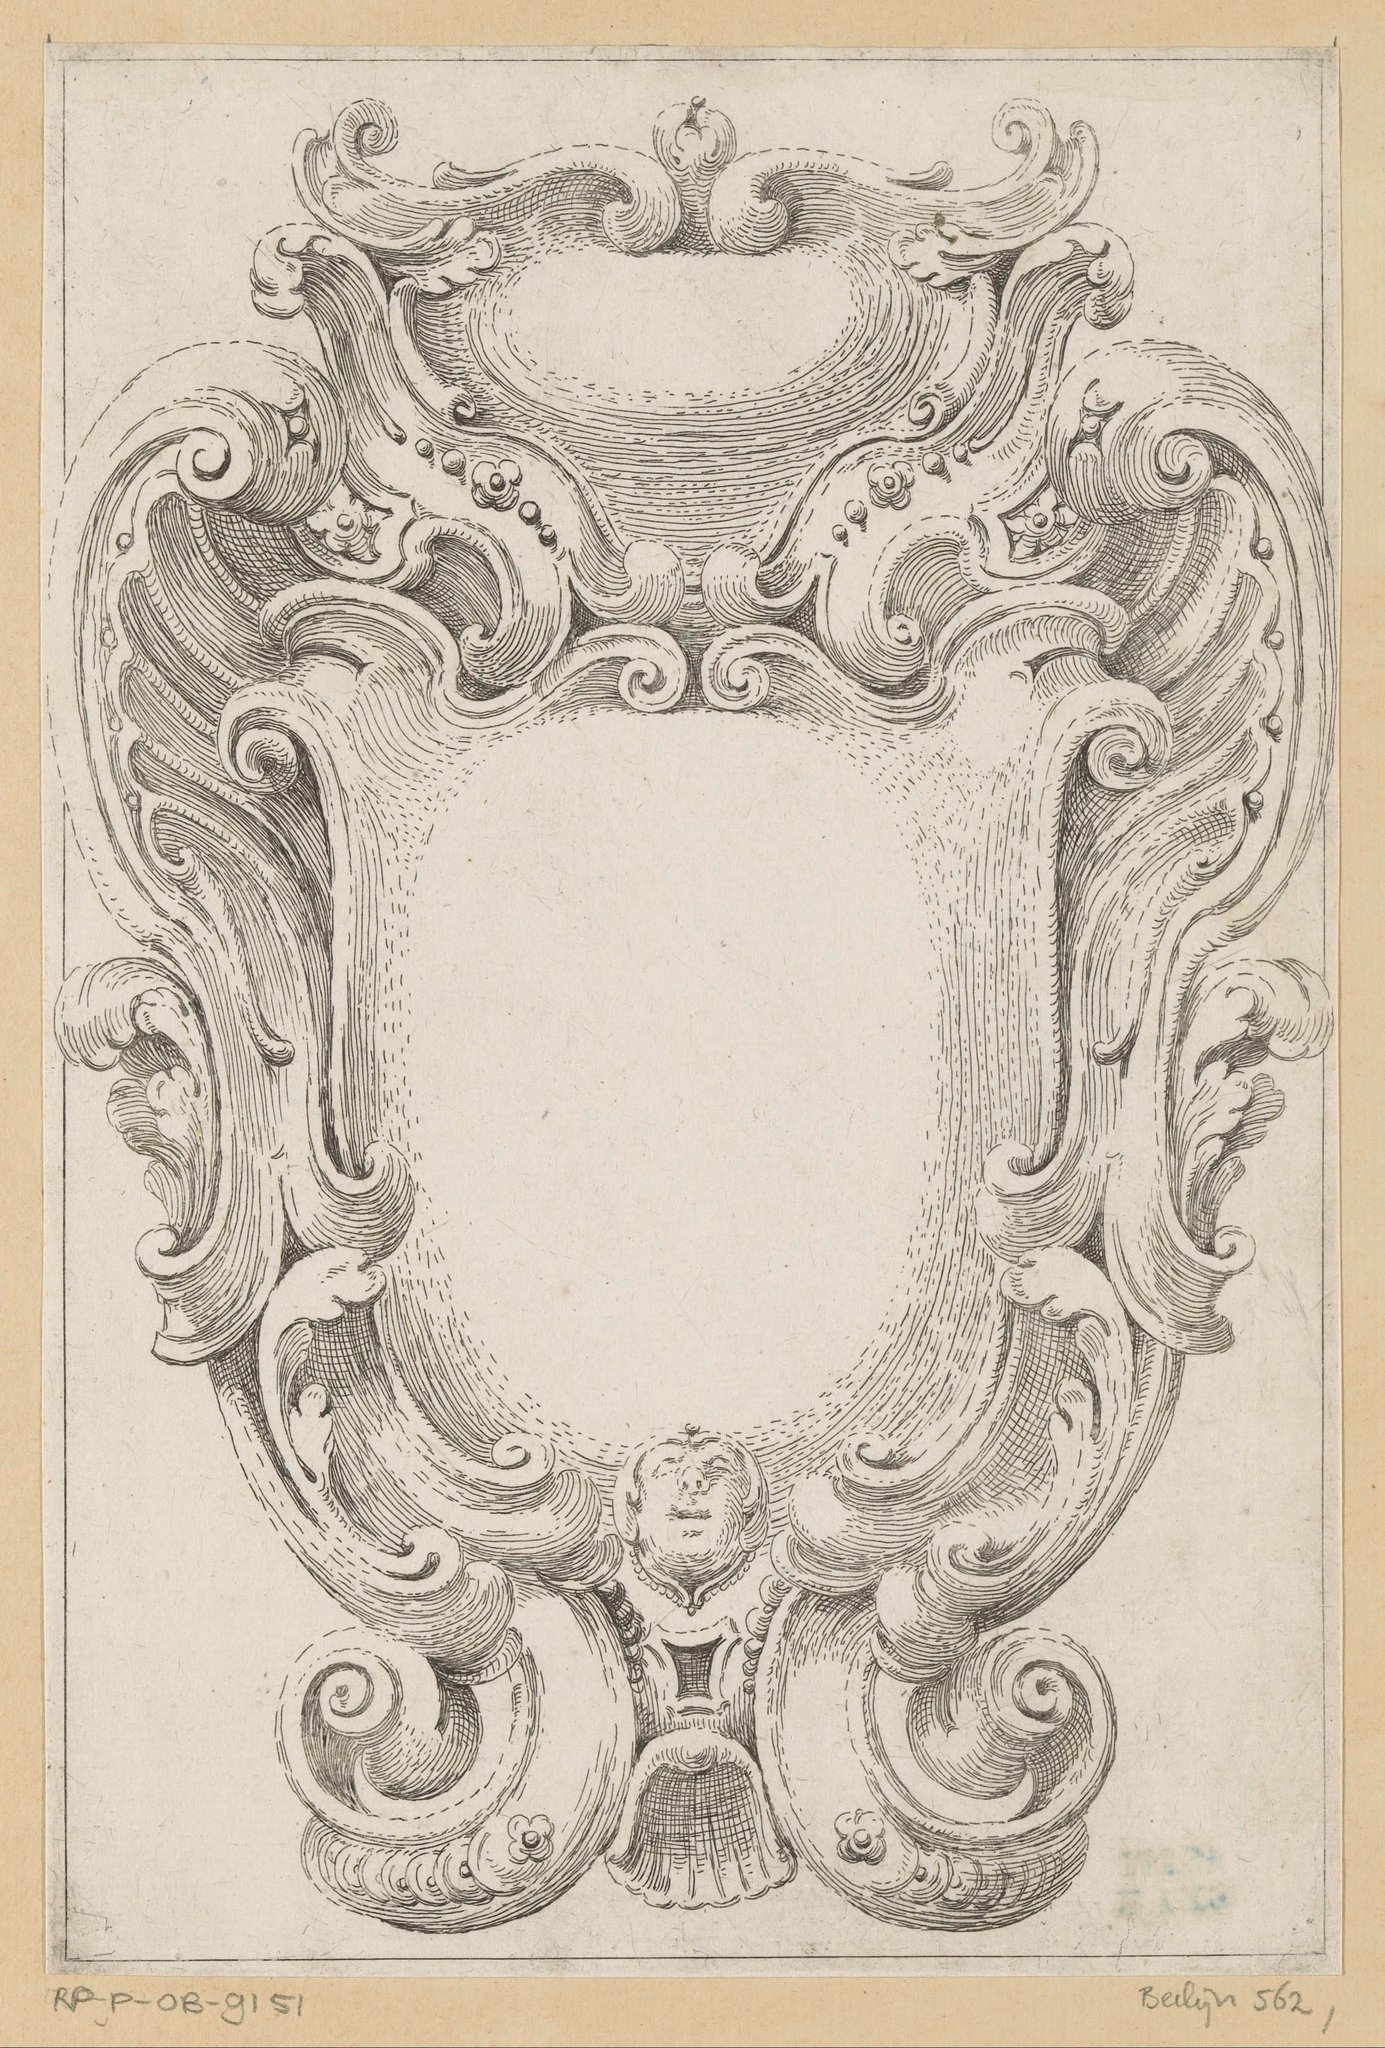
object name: print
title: Cartouches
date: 1636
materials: paper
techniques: etching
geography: italy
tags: ornament ~ cartouche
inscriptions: collector's mark: Lugt 2165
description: Deze prent maakt deel uit van een reeks van 22 prenten met in totaal 24 cartouches, plus een titelprent.